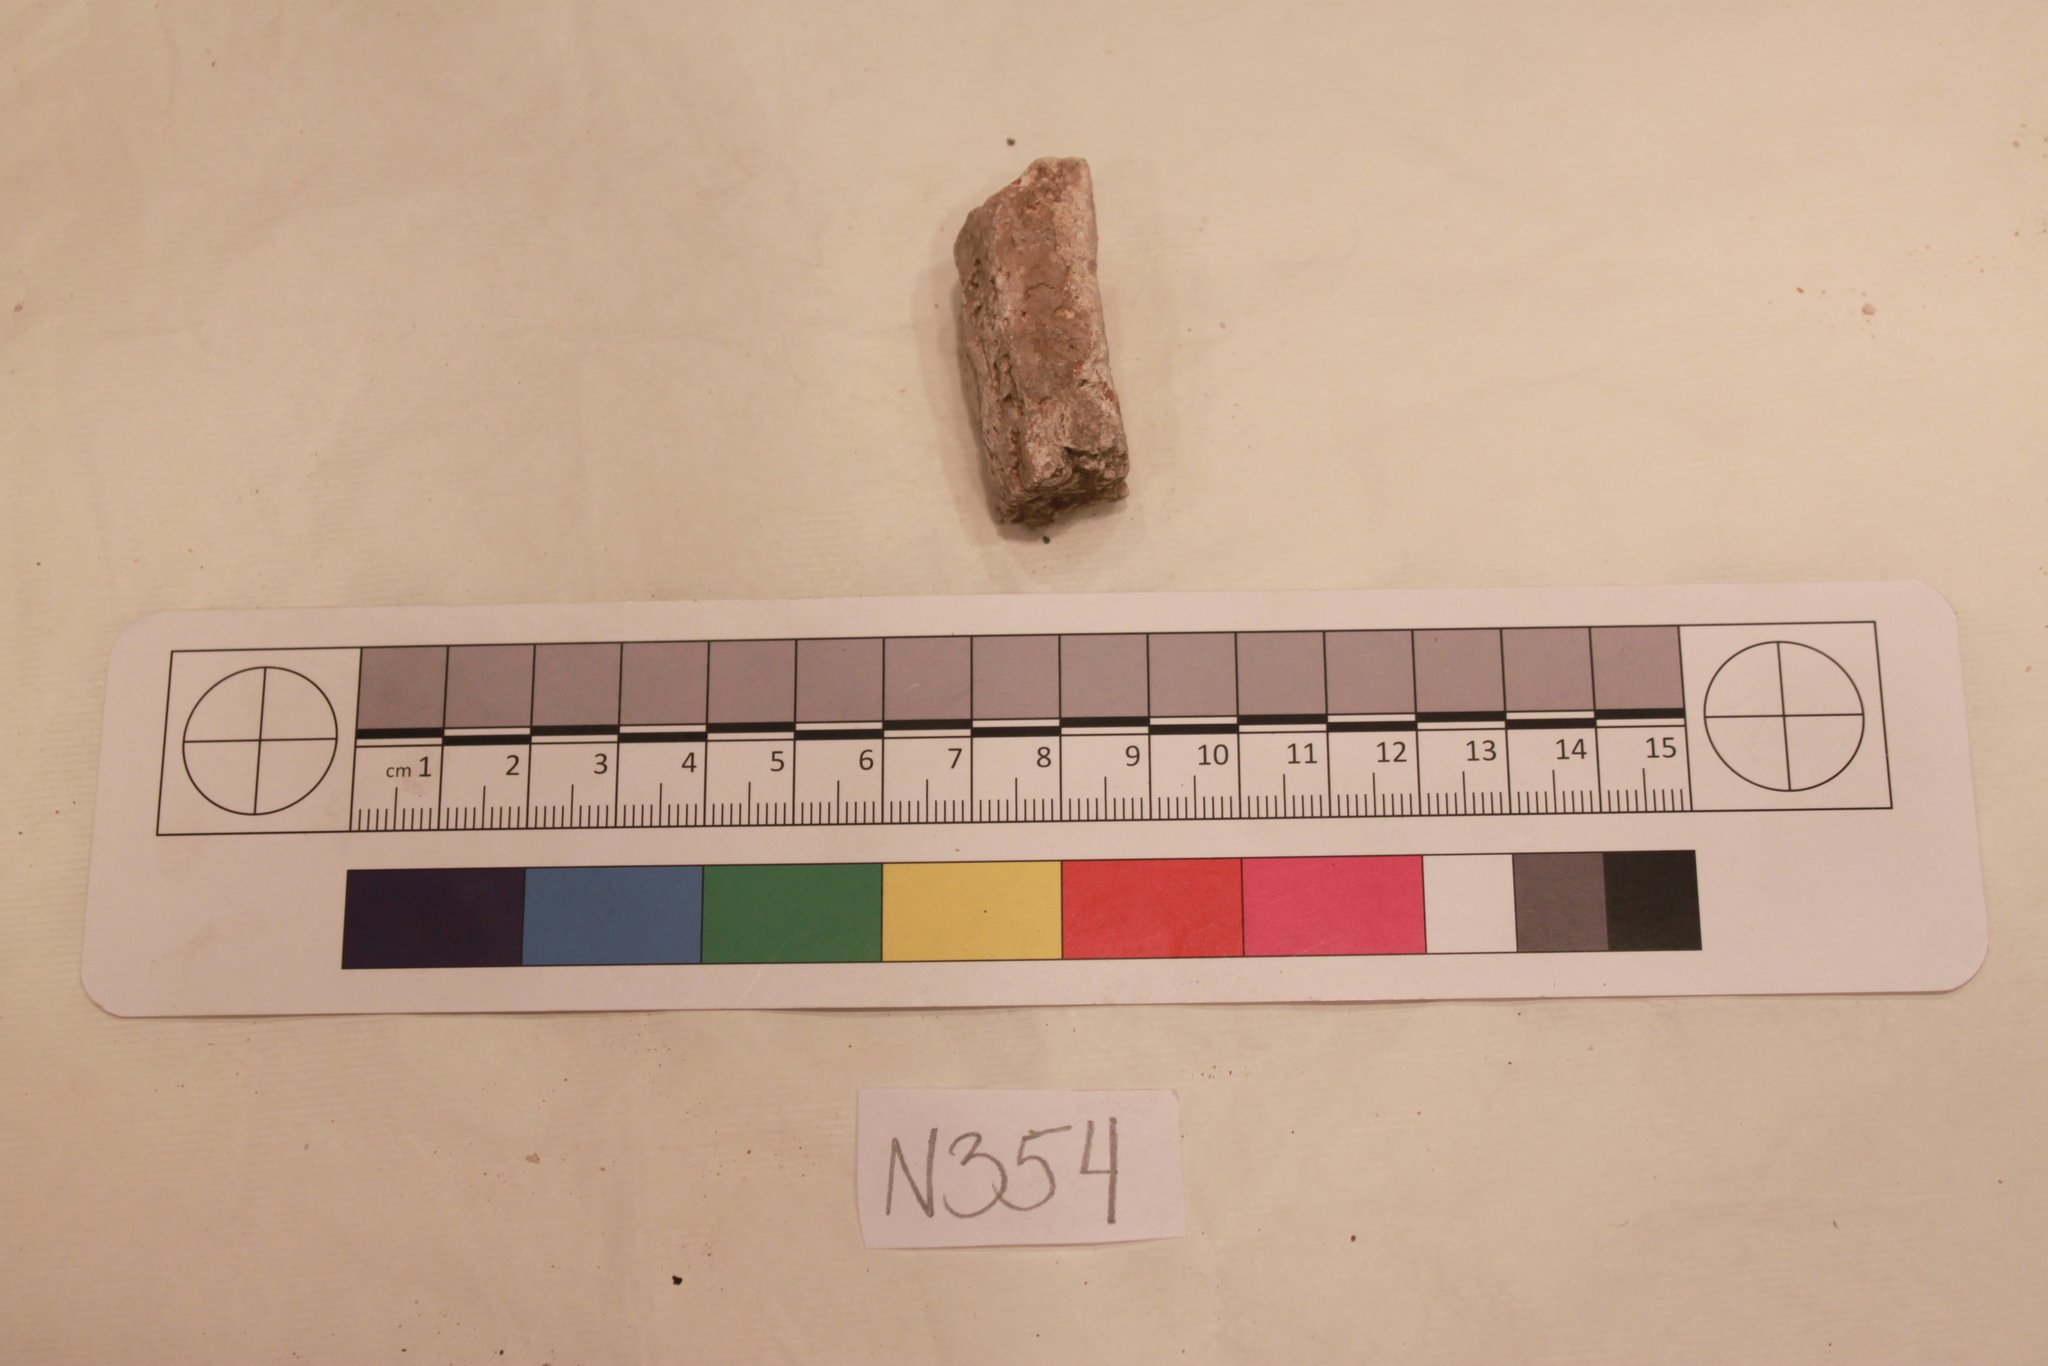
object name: fragment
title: Stucco Fragment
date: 701-1200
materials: plaster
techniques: carving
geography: iran